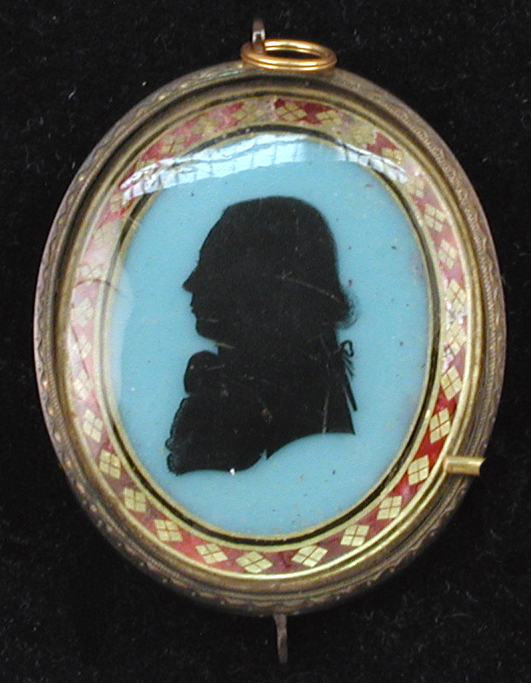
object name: locket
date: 1701-1800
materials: glass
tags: men,profiles